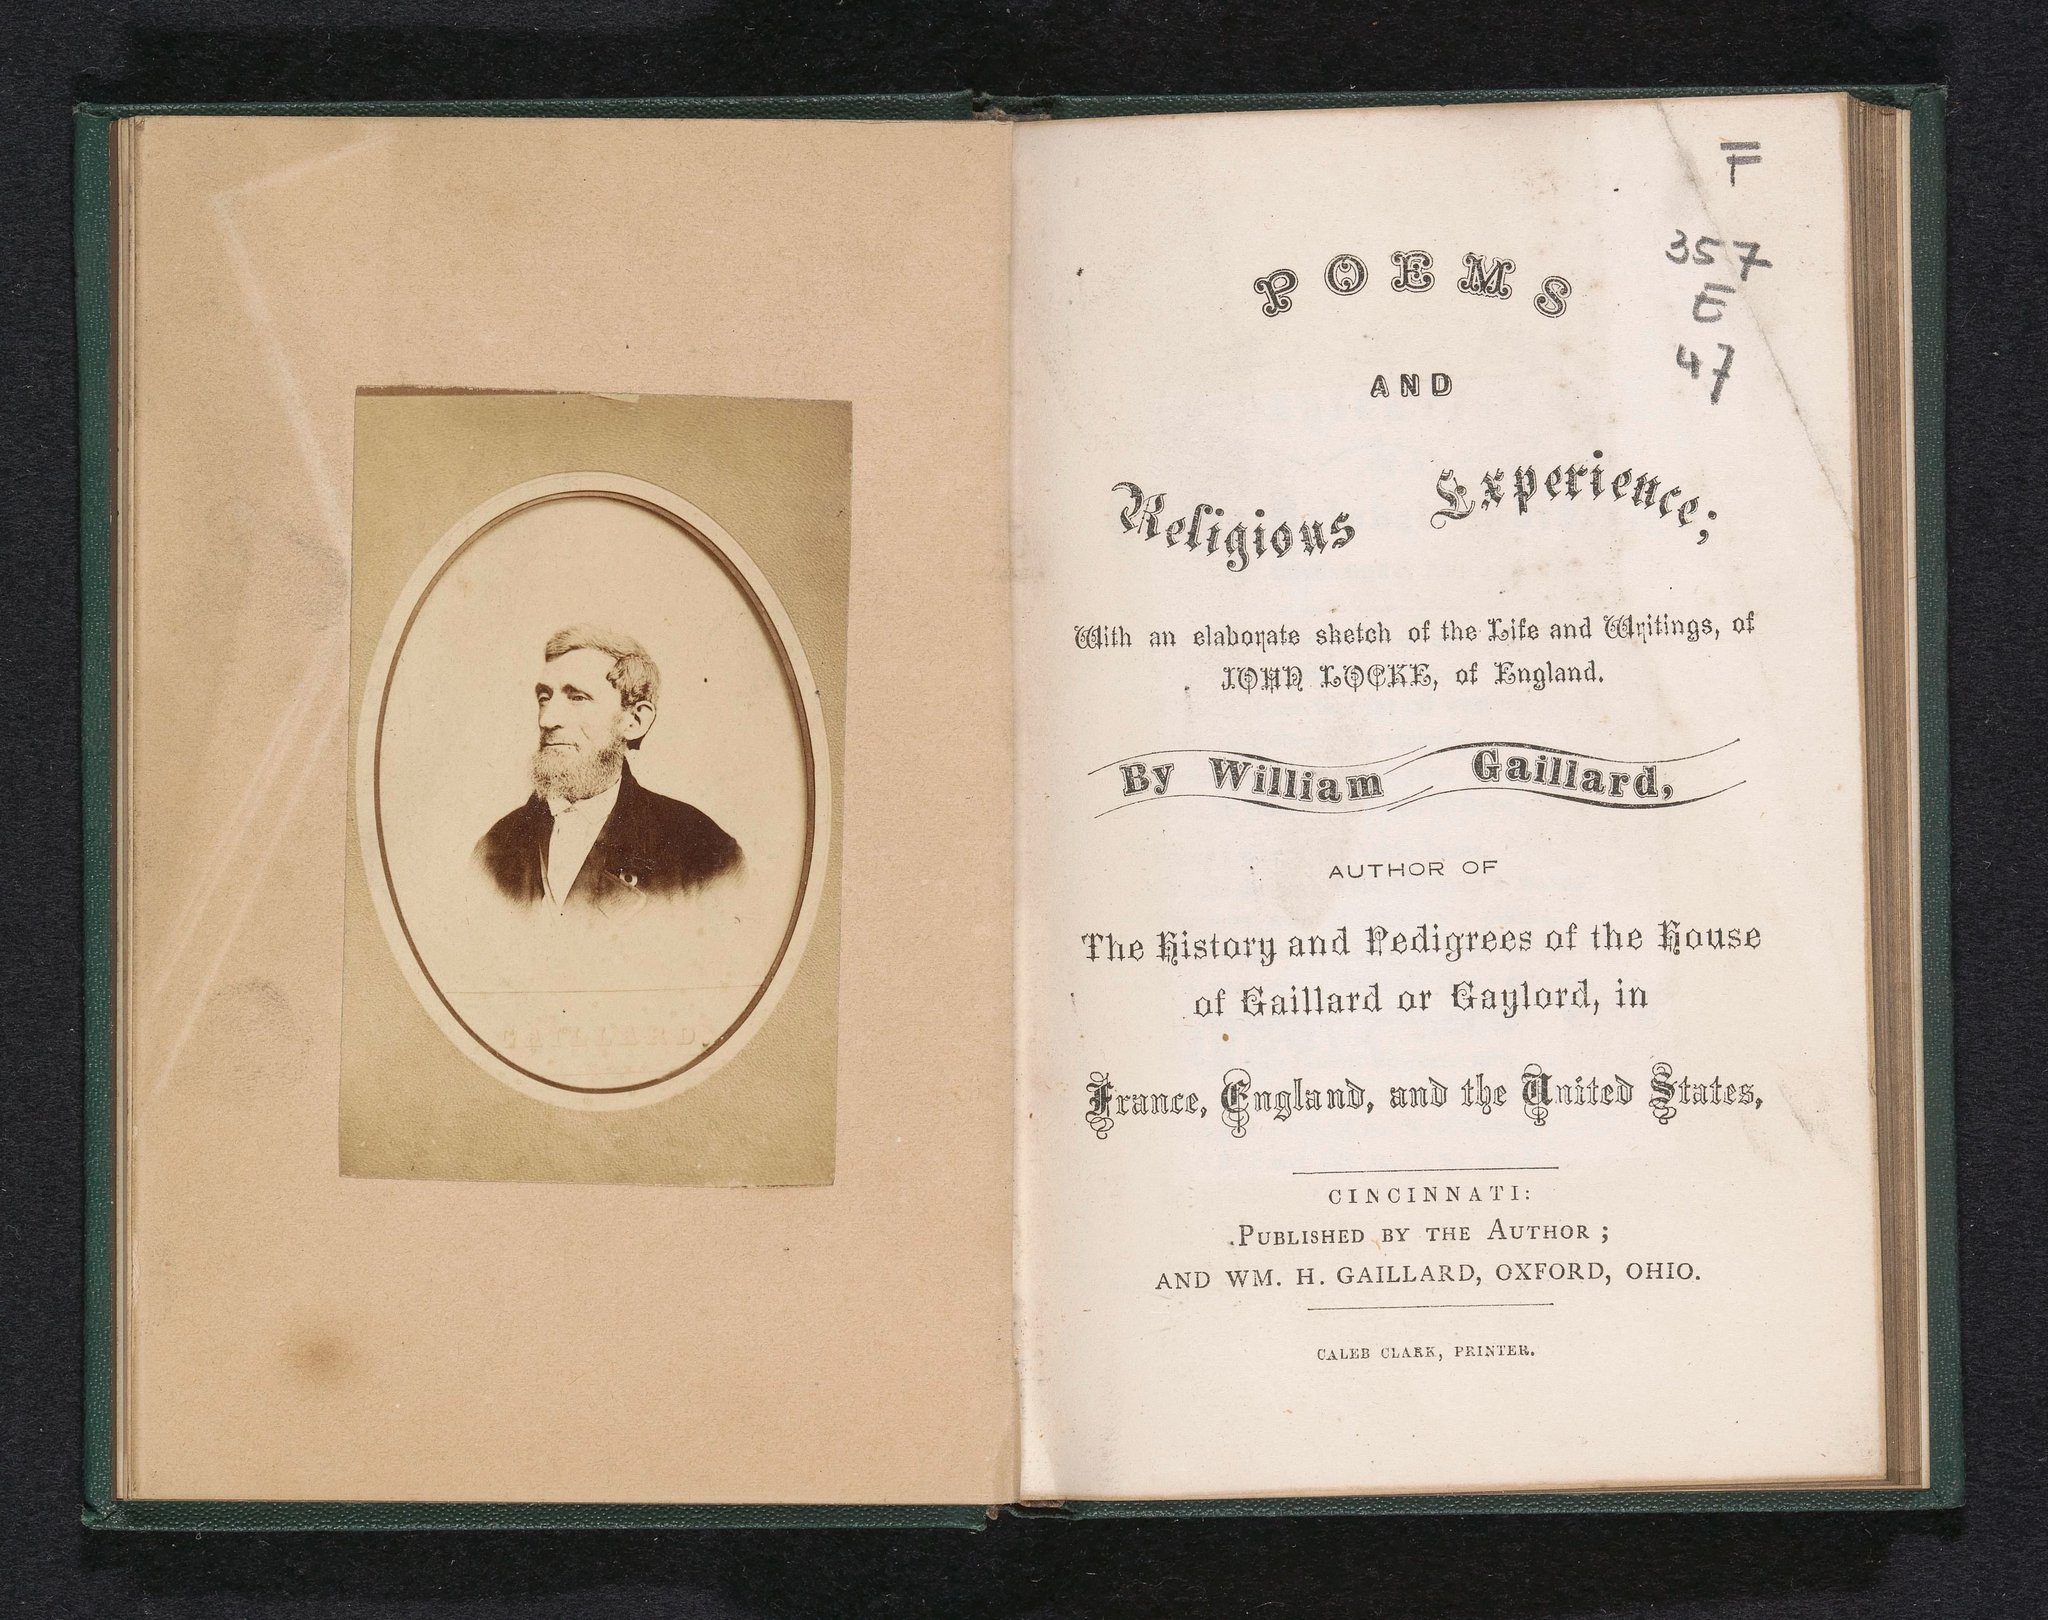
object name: photograph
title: Portret van vermoedelijk William Gaillard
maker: Anonymous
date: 1865-1875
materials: photographic support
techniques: albumen print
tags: william gaillard, portrait of a writer